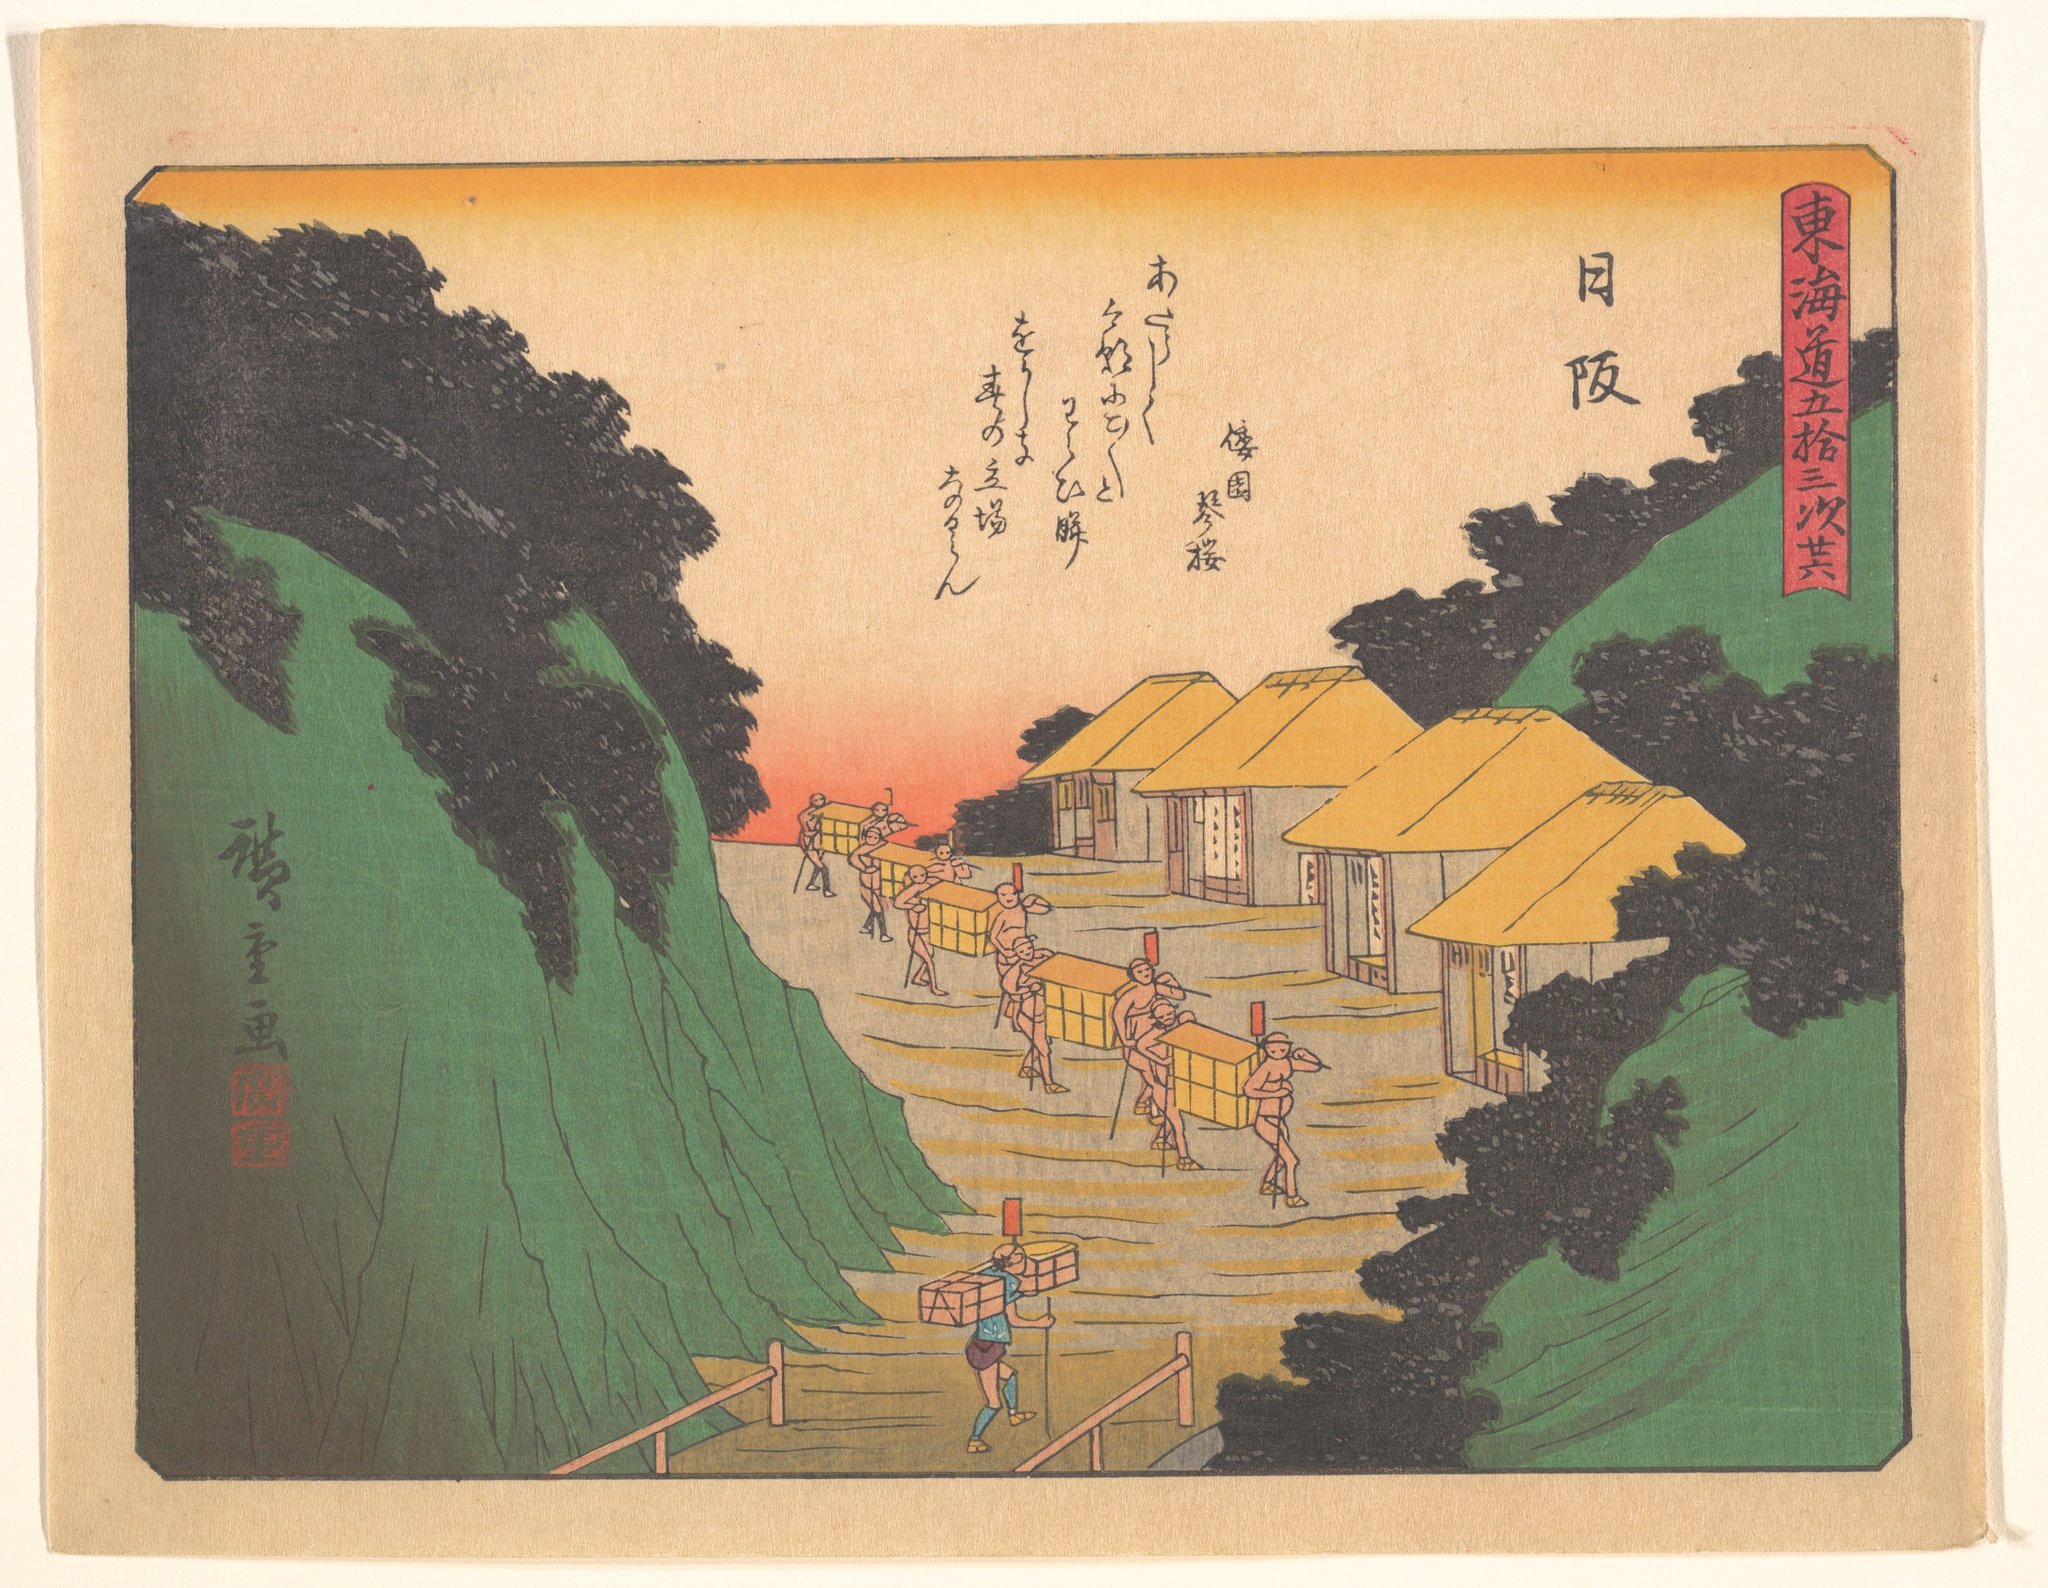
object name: print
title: 東海道五十三次 日阪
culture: japanese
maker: utagawa hiroshige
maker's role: artist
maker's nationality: japanese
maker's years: 1797-1858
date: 1901-1933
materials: ink, paper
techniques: woodblock print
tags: human figures